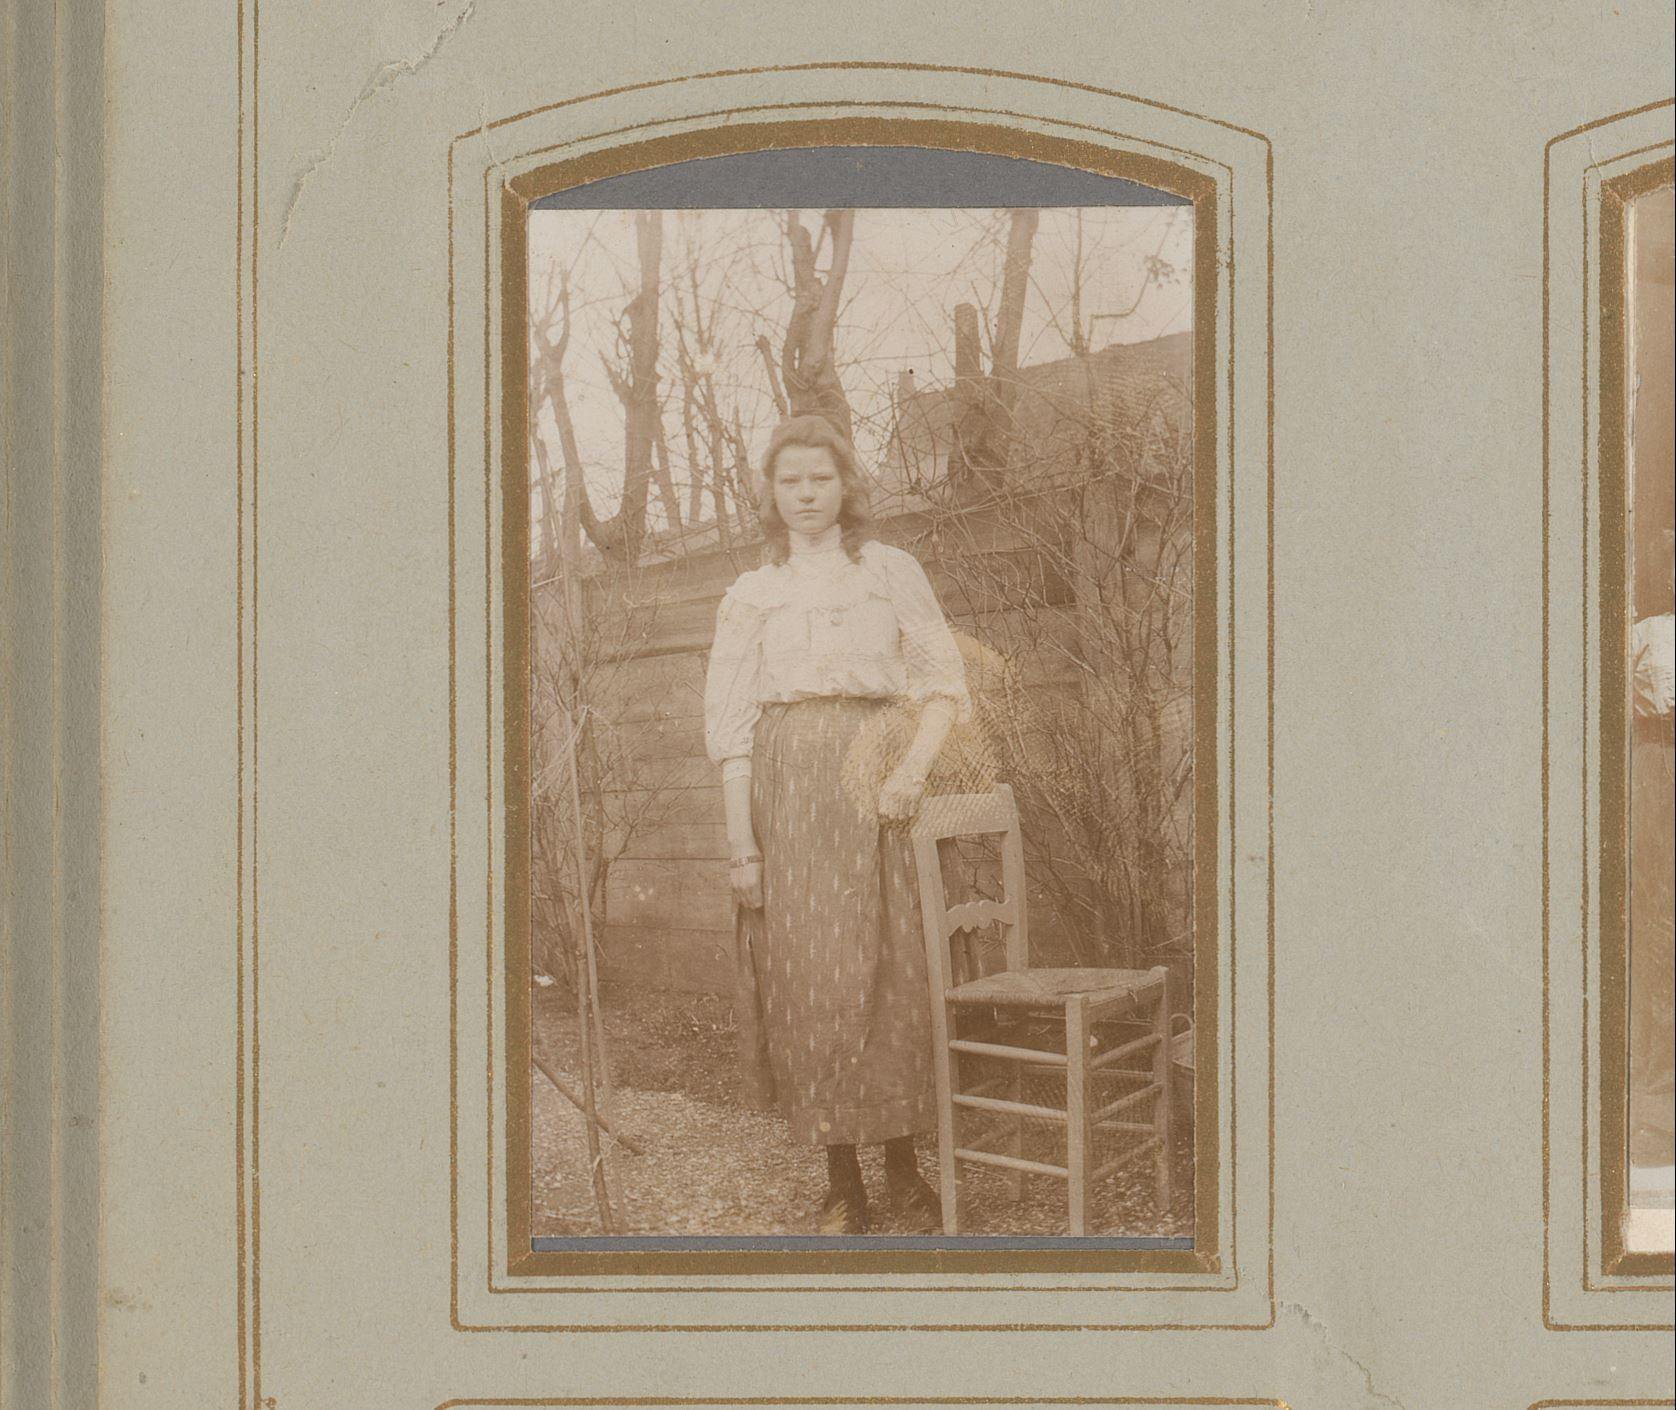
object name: album leaf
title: Portret van een jonge vrouw, staand in een tuin bij een stoel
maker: Anonymous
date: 1880-1920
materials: cardboard, photographic support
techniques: collodion silver print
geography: netherlands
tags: historical persons - bb - woman, garden, chair